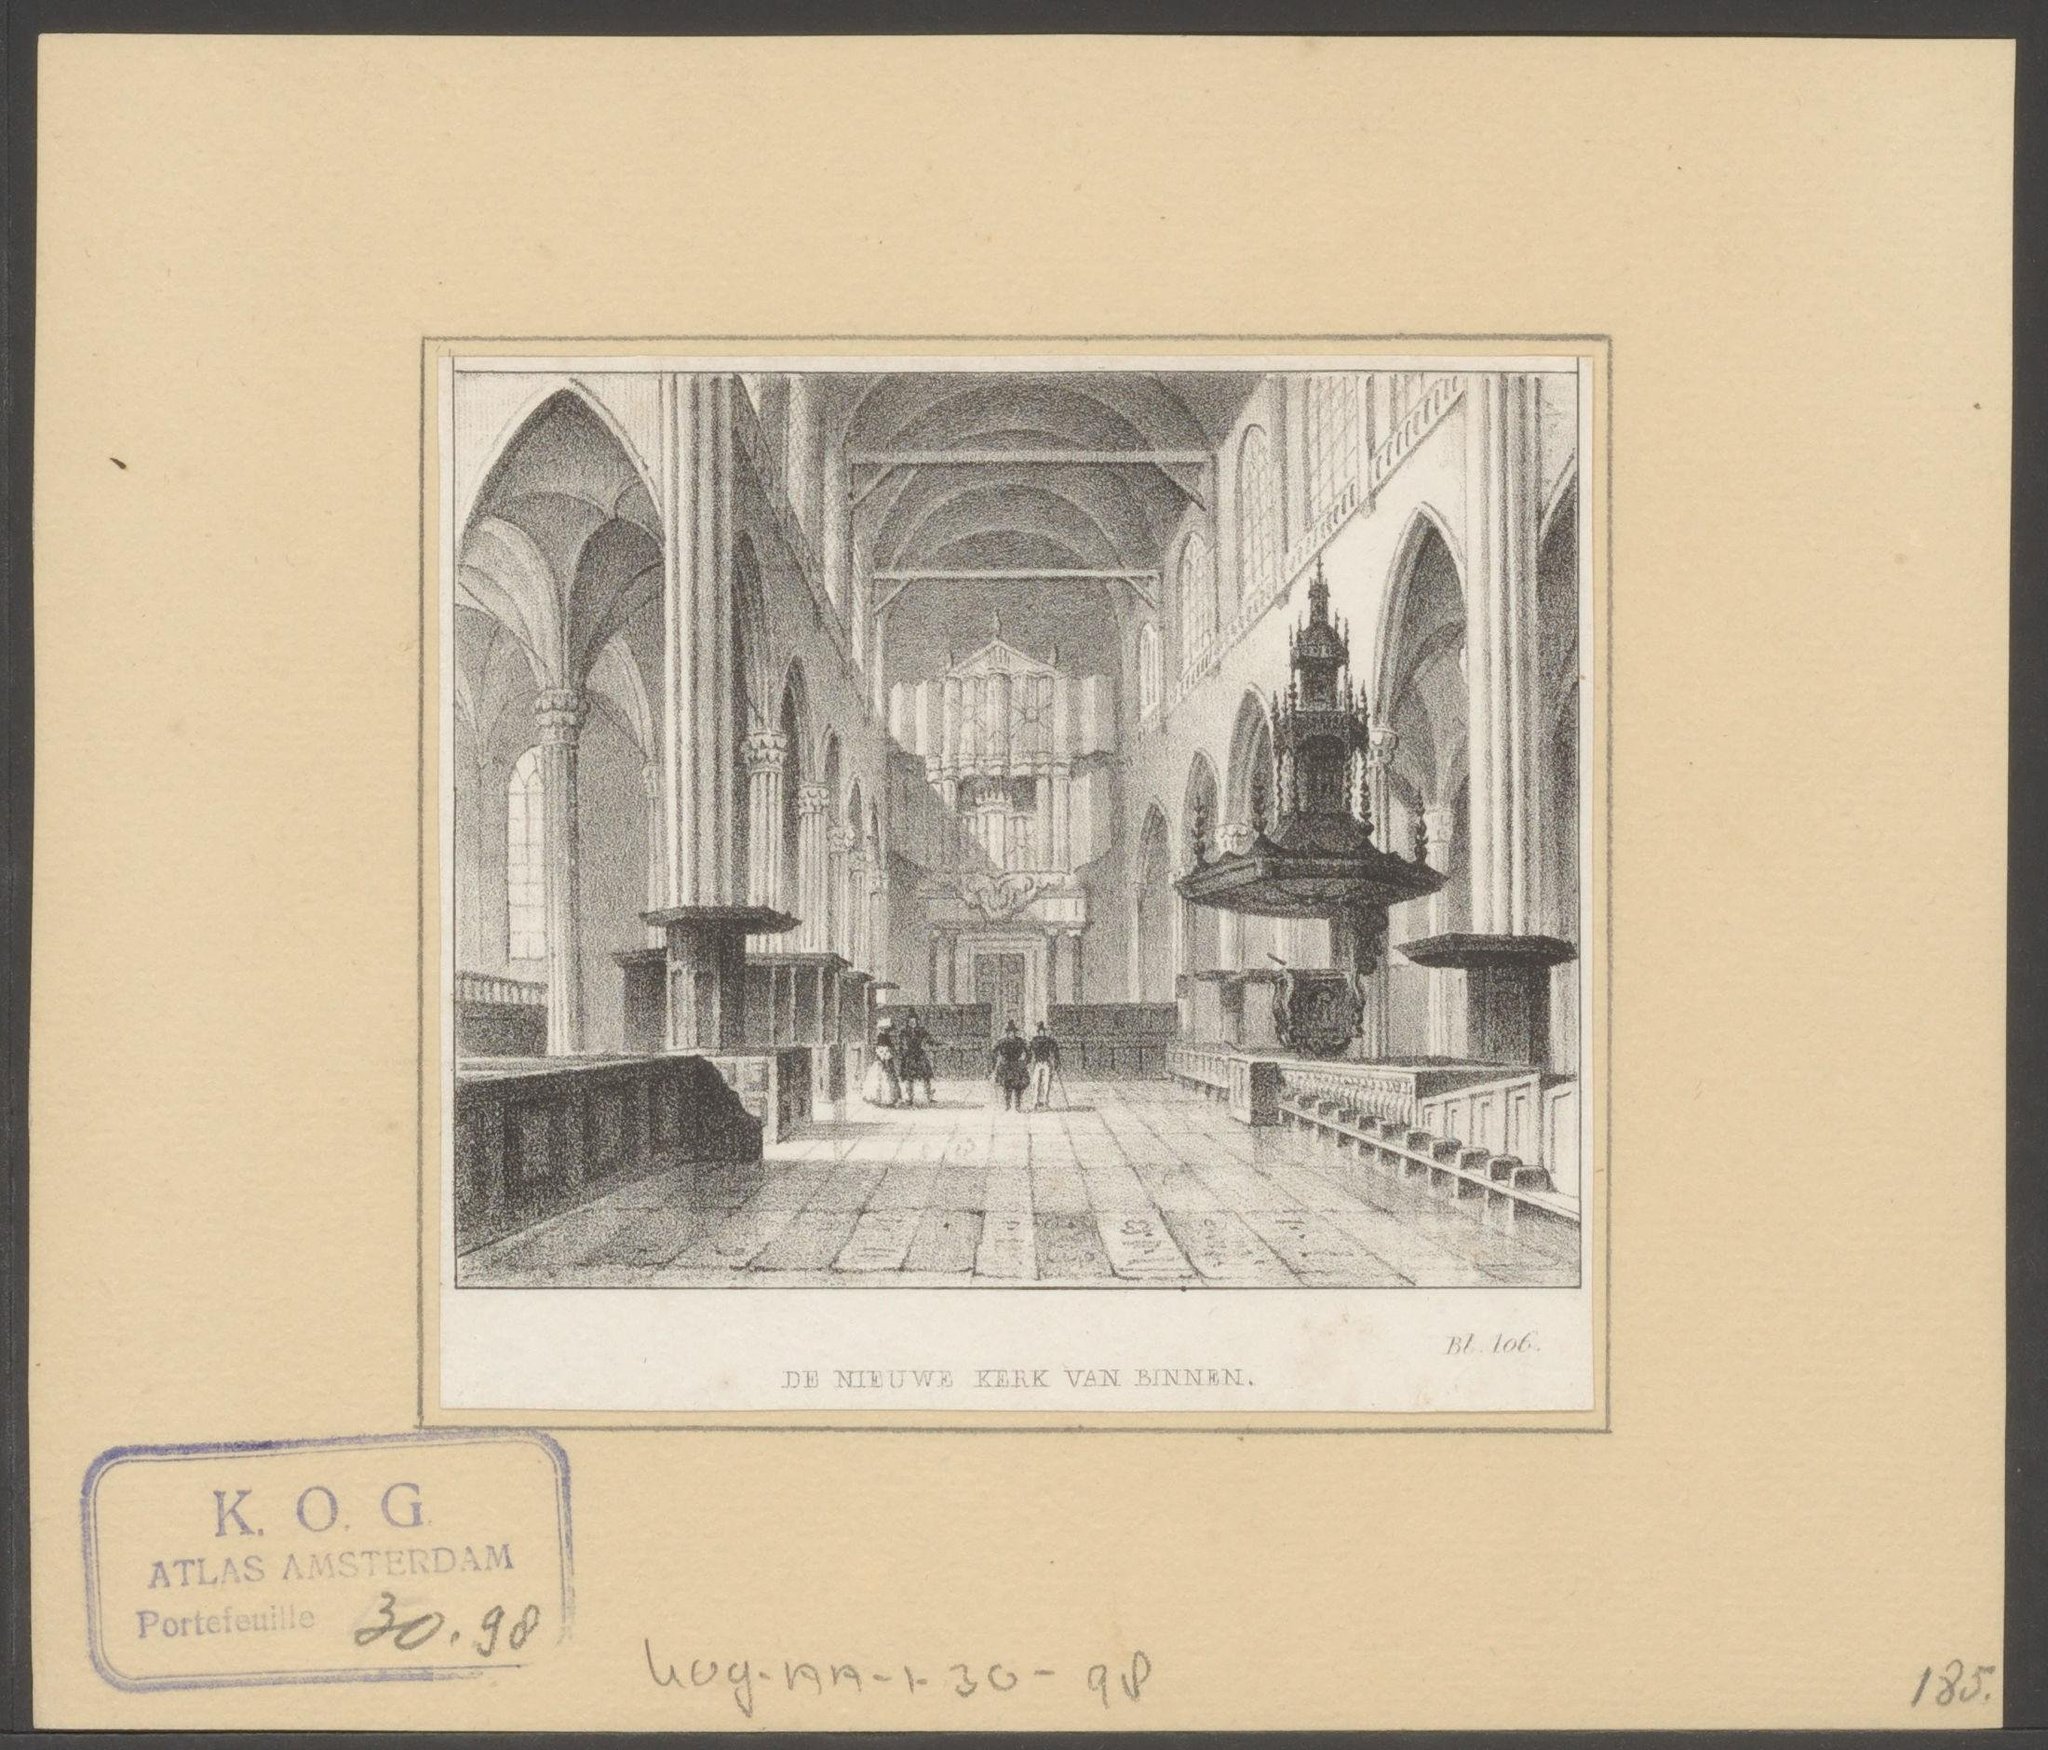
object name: print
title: Interieur van de Nieuwe Kerk te Amsterdam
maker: johannes hilverdink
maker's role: draughtsman, painter, print maker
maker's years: 1813-1902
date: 1844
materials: paper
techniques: lithograph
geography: netherlands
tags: interior of church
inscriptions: collector's mark: Lugt 1641b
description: Prent uit: Vijver, Cornelis van der. Geschiedkundige Beschrijving der Stad Amsterdam (...). Amsterdam: Gebroeders Diederichs, 1844, dl. 1.